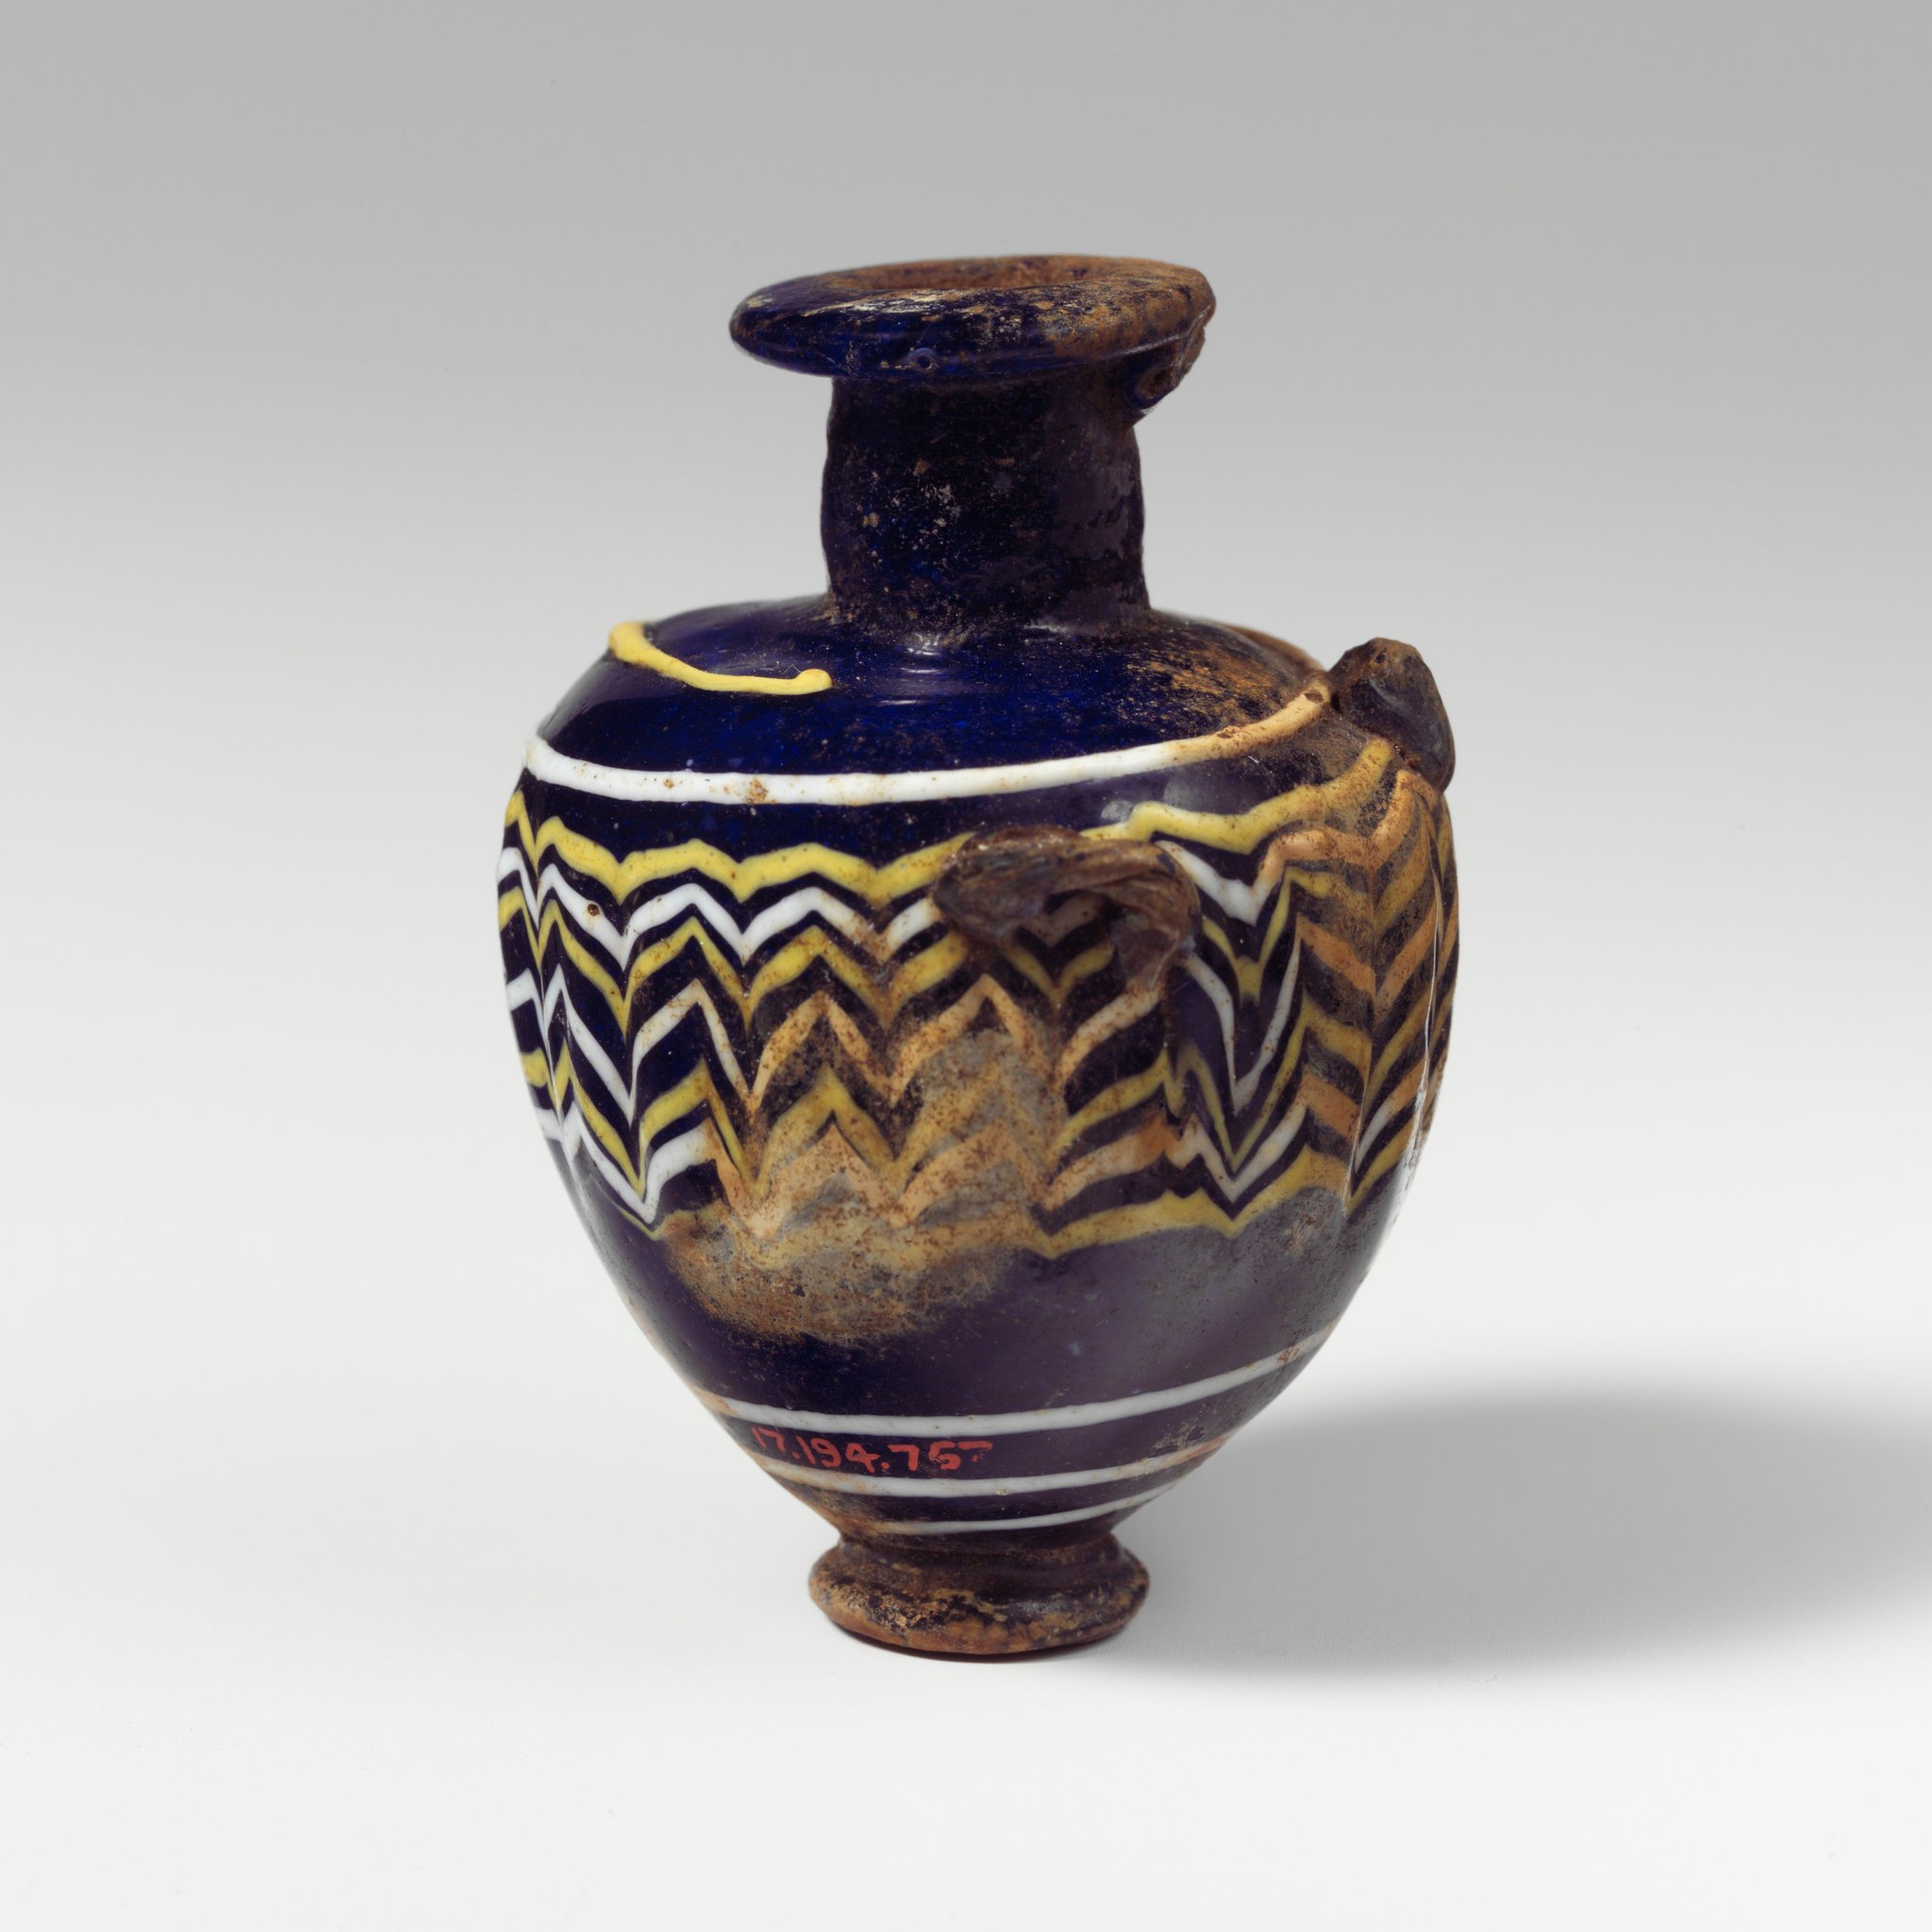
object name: hydriske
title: Glass hydriske (perfume bottle)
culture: greek, eastern mediterranean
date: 334-201 BCE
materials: glass